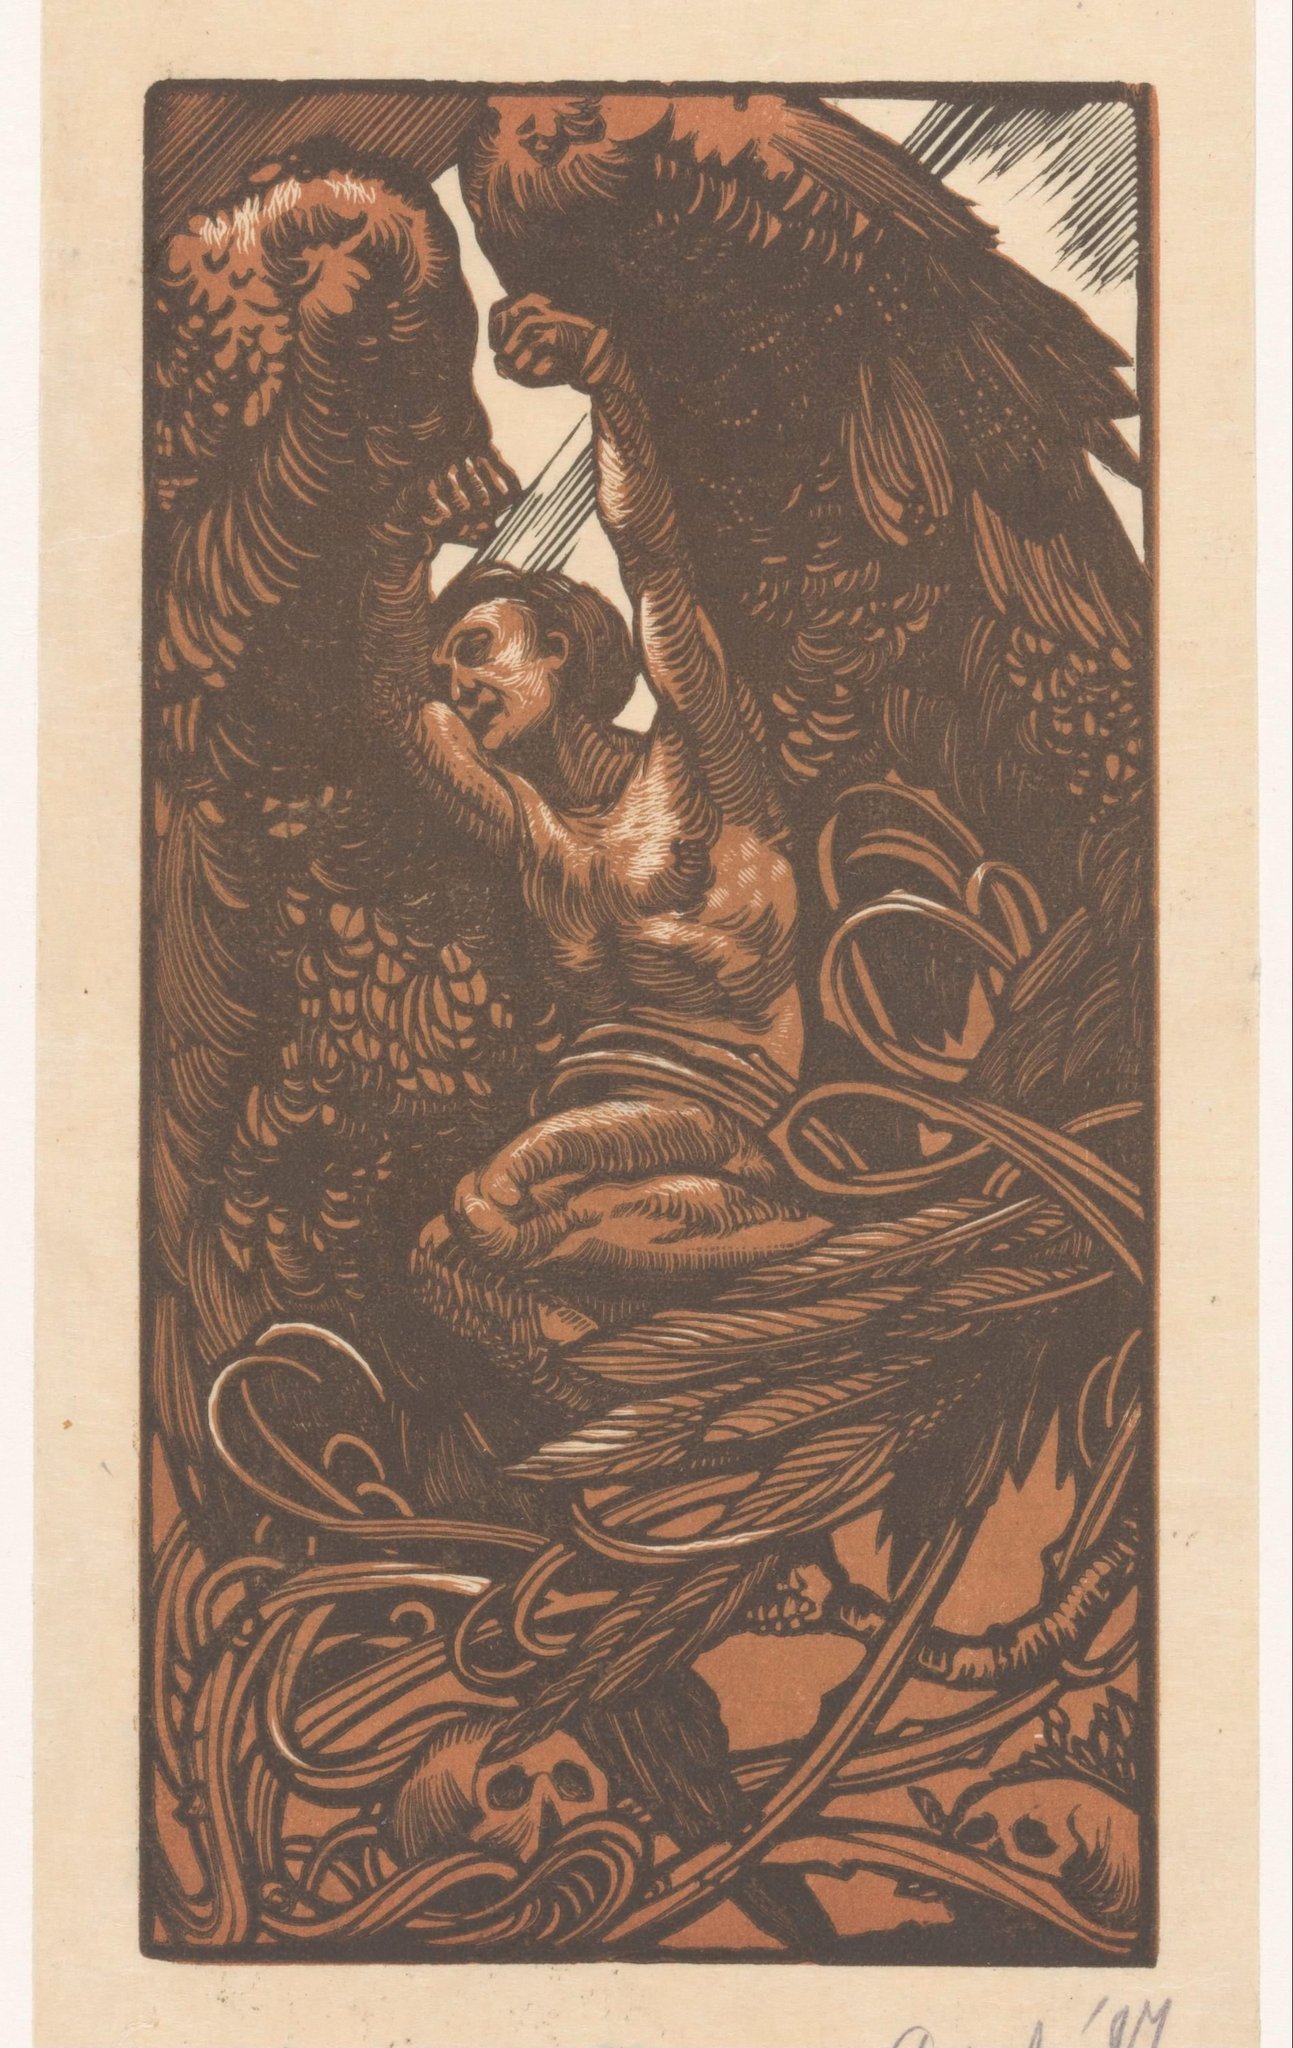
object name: print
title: Prometheus geboeid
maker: johannes josephus aarts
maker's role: draughtsman, print maker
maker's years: 1871-1934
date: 1897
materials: paper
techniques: woodcut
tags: punishment of prometheus; he is chained to a rock, usually by vulcan and/or mercury, death's head, skull (symbol of death)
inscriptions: collector's mark: Lugt 2166, collector's mark: Lugt 2760, collector's mark: Lugt 2228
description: Prometheus staat met een van zijn voeten op een tak en steekt beide armen, met daaraan vleugels, de lucht in. Zijn handen lijken geboeid. Op de achtergrond zonnestralen. Onder de tak twee schedels.